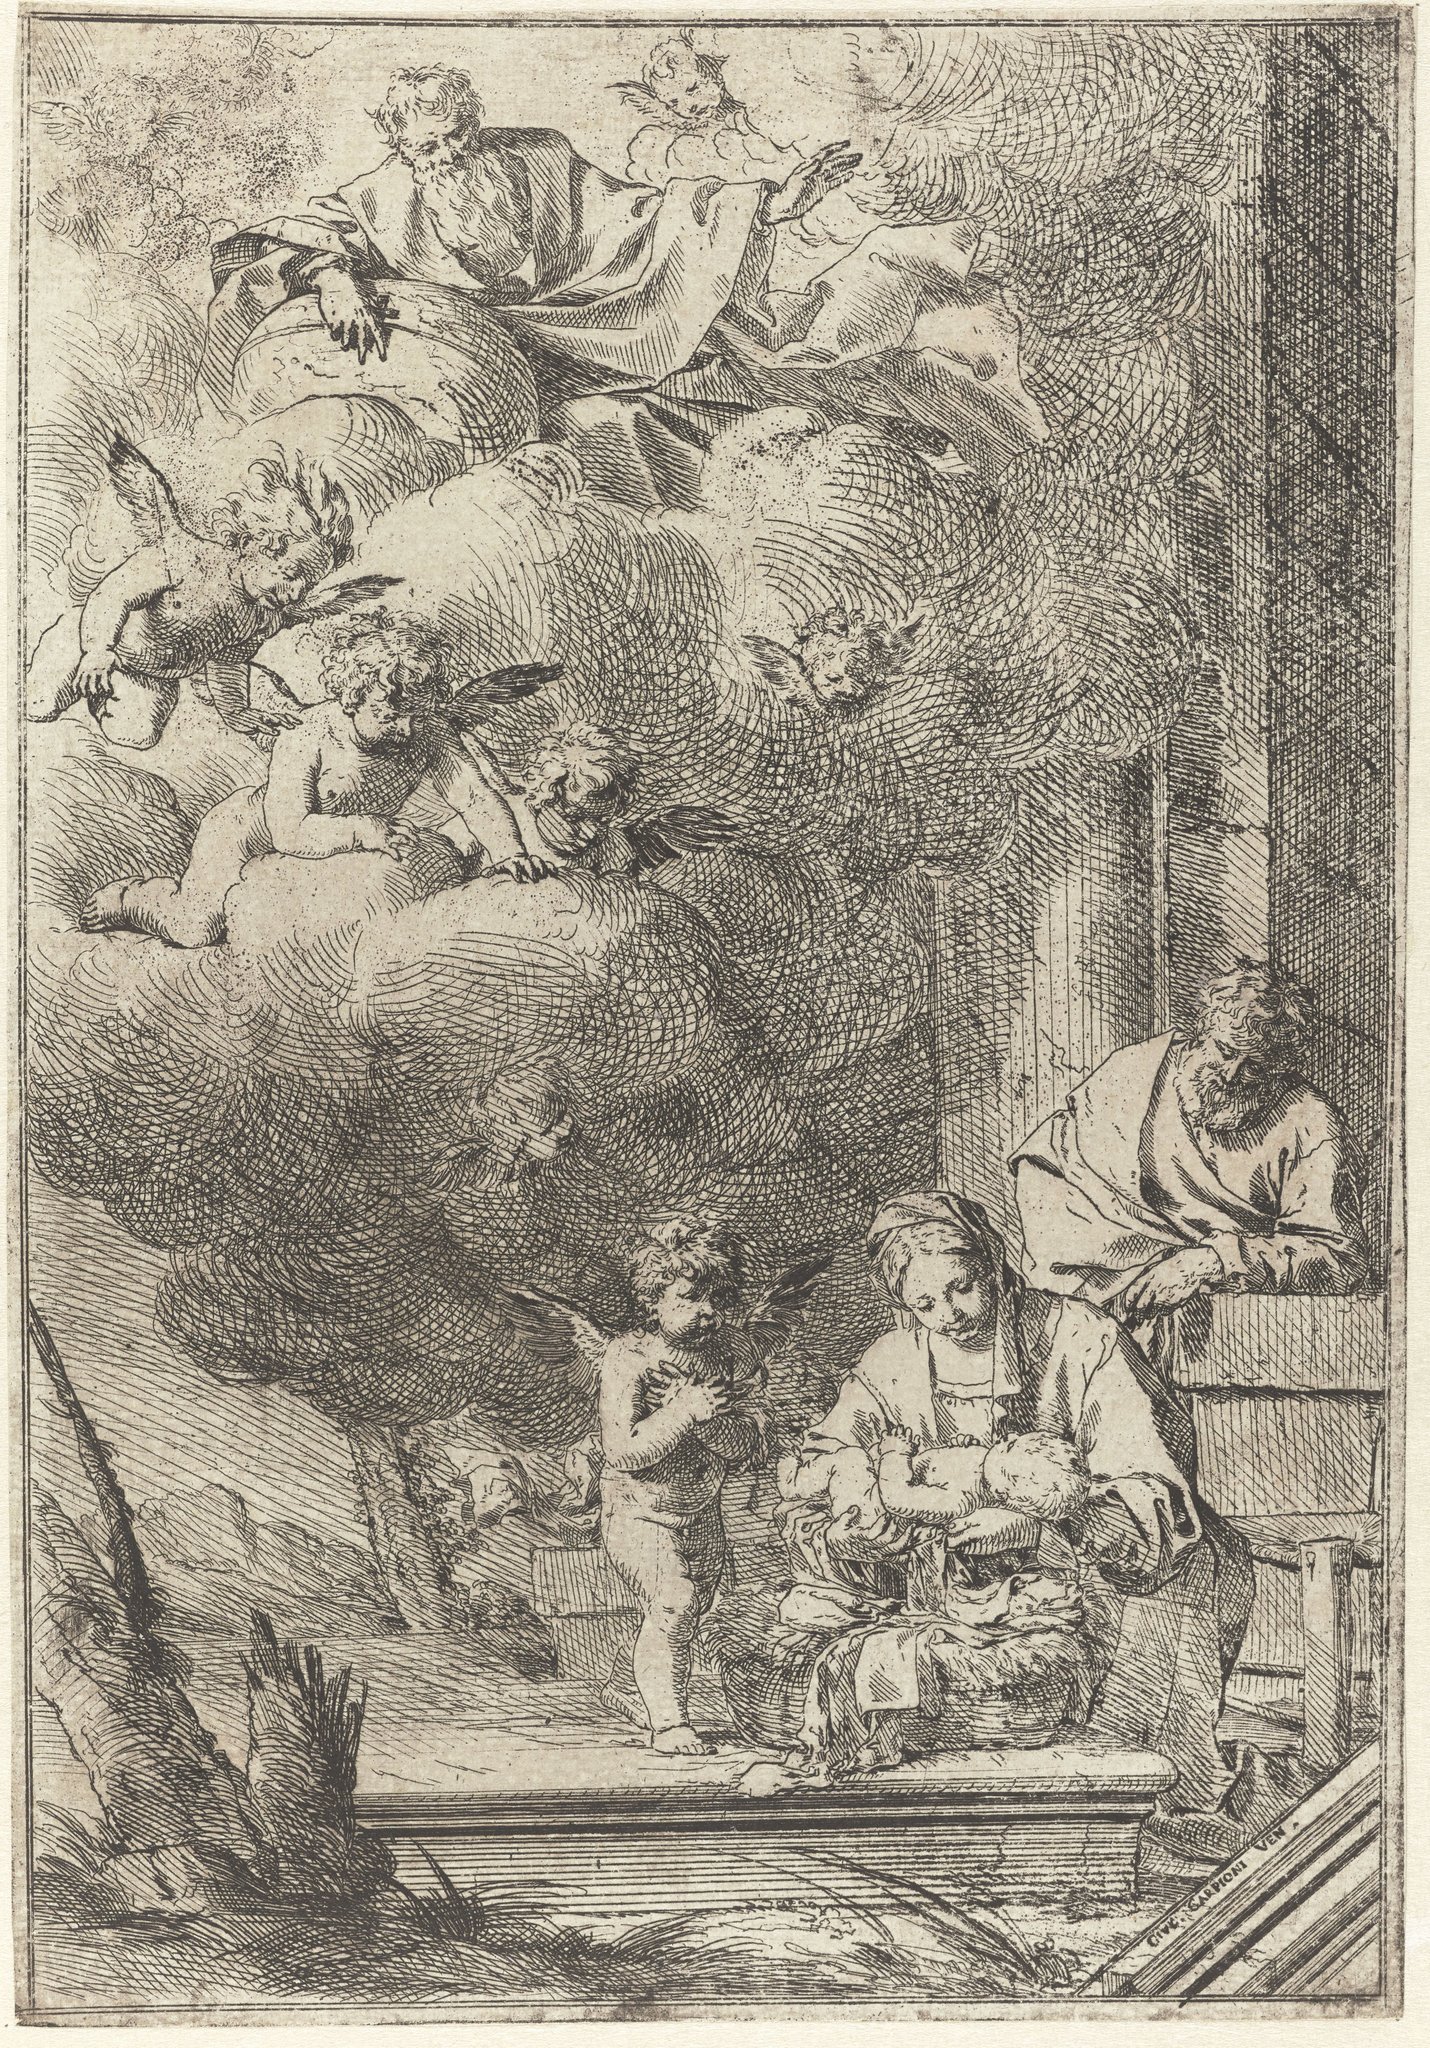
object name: print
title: Geboorte van Christus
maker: giulio carpioni (i)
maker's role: draughtsman, print maker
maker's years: 1613-1679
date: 1621-1674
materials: paper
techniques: etching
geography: venice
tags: god the father, mary, joseph and the new-born christ (nativity)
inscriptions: collector's mark: Lugt 2228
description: Maria zit met het Christuskind op schoot voor een tempel. Jozef staat achter haar en leunt tegen een muurtje. Een engel aanbidt het Christuskind. Boven kijken God de Vader en putti toe.